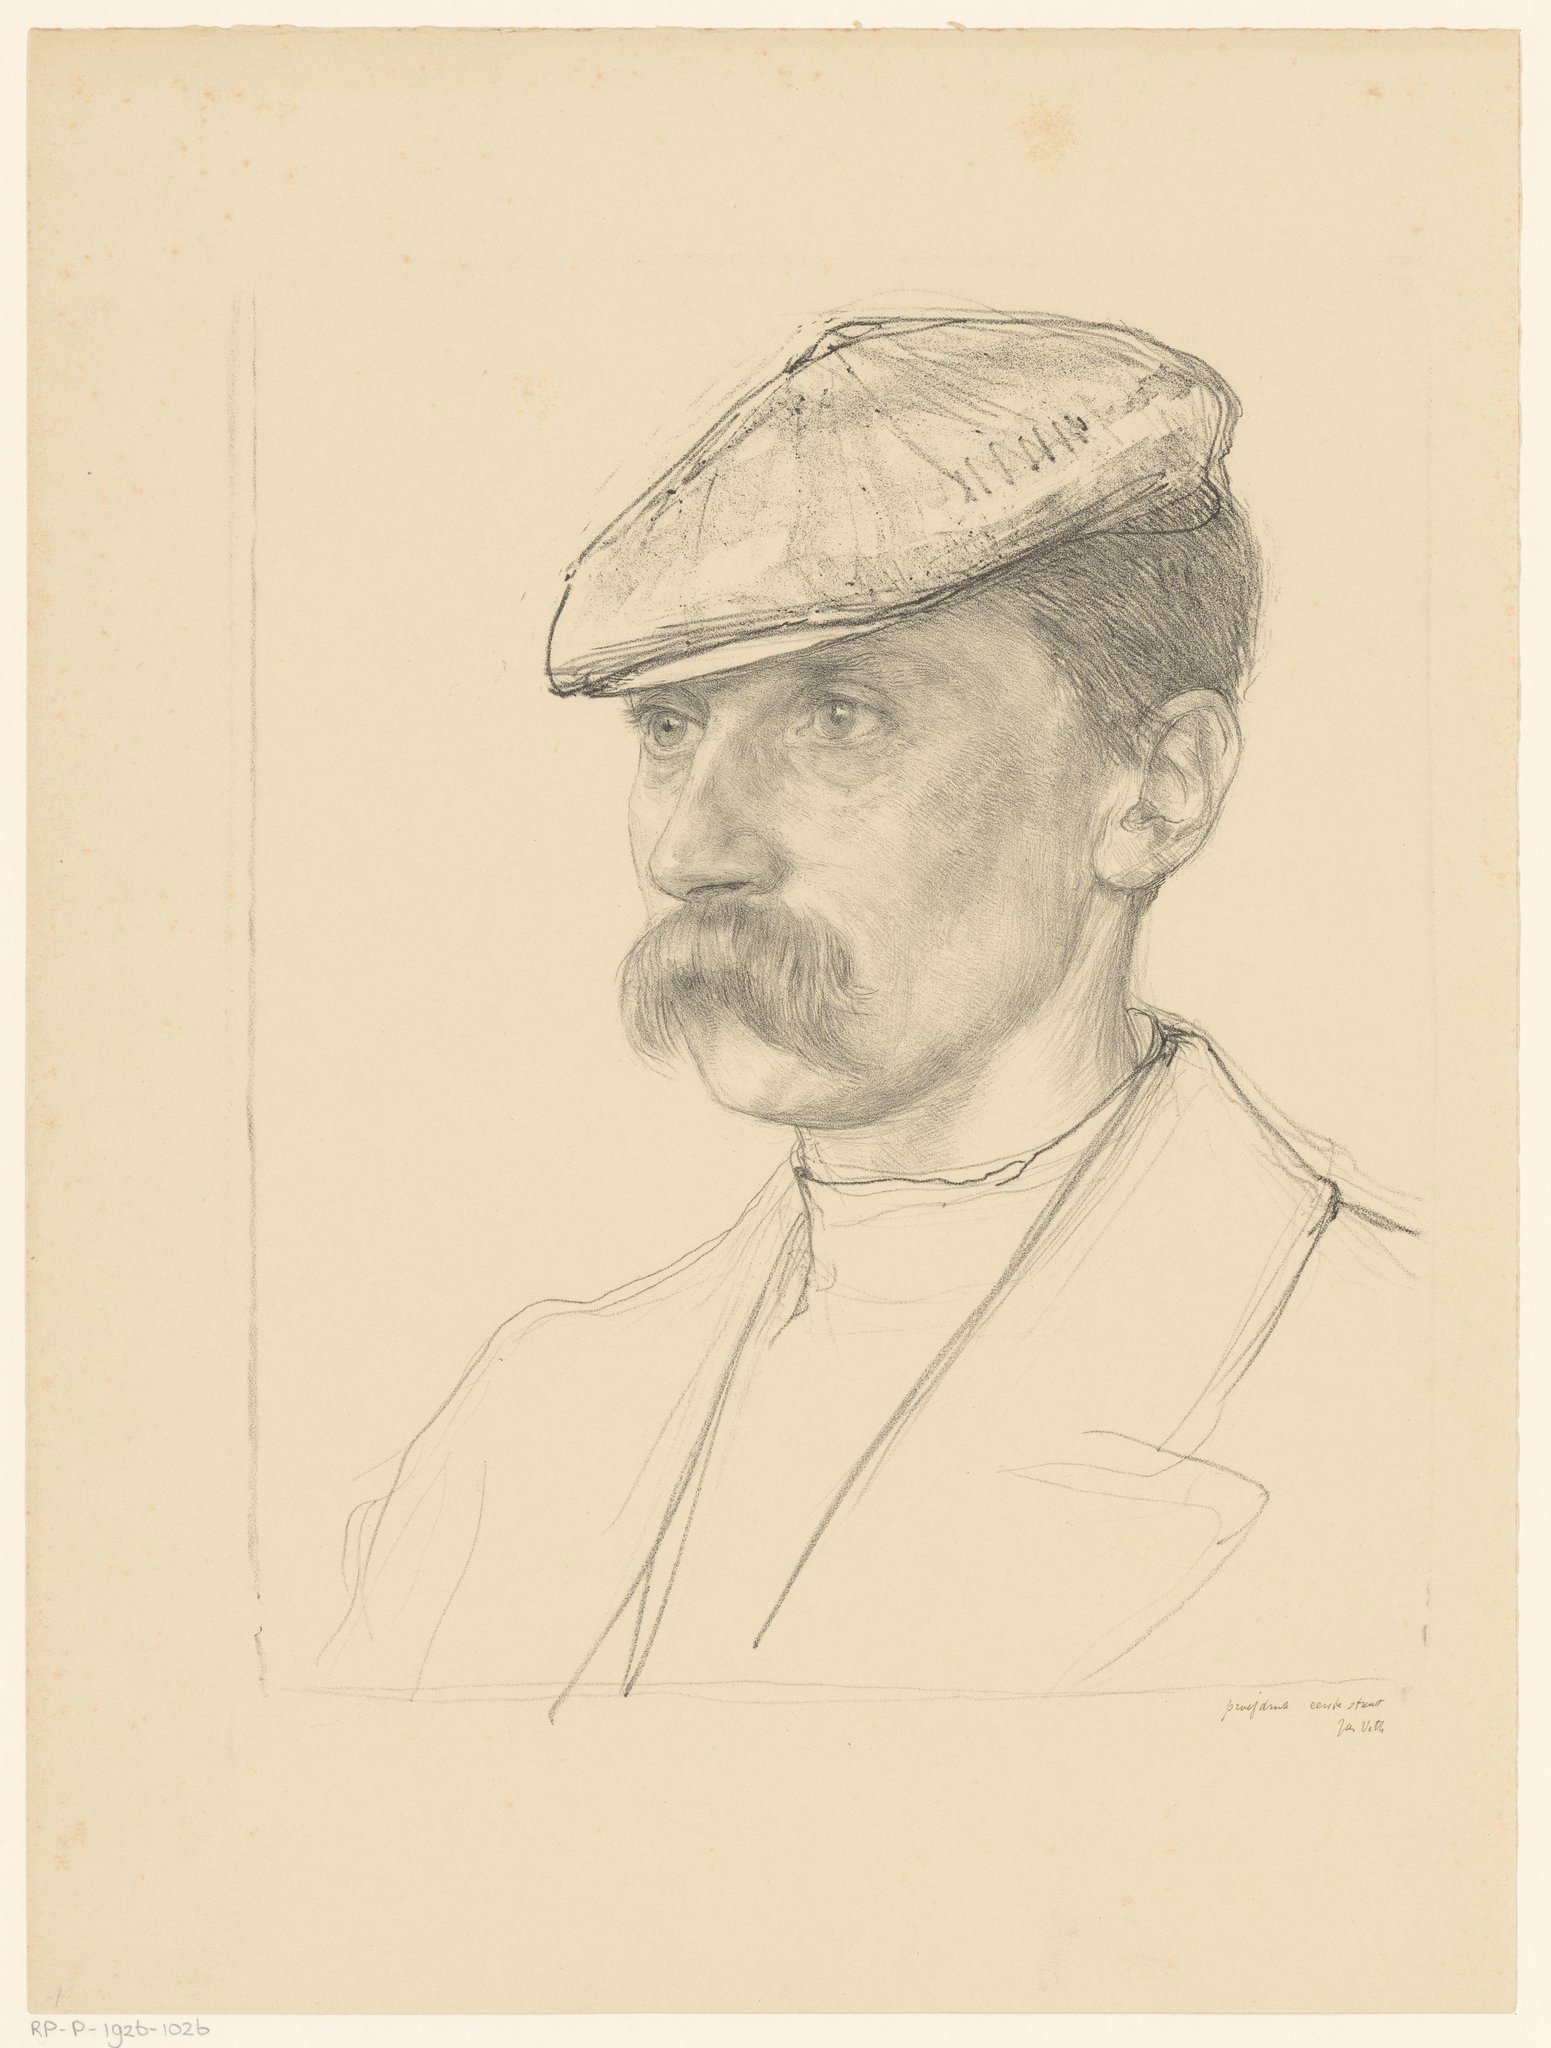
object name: print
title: Portret van Cornelis Gerardus 't Hooft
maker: jan veth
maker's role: designer, draughtsman, painter, print maker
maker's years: 1864-1925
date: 1891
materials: paper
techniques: lithograph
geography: netherlands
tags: dordrecht, amsterdam, painter, draughtsman, cornelis gerardus 't hooft, historical persons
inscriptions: collector's mark: Lugt 2228, collector's mark: ‘H.G. Samson Amsterdam’, inscription: ‘proefdruk eerste staat / Jan Veth’